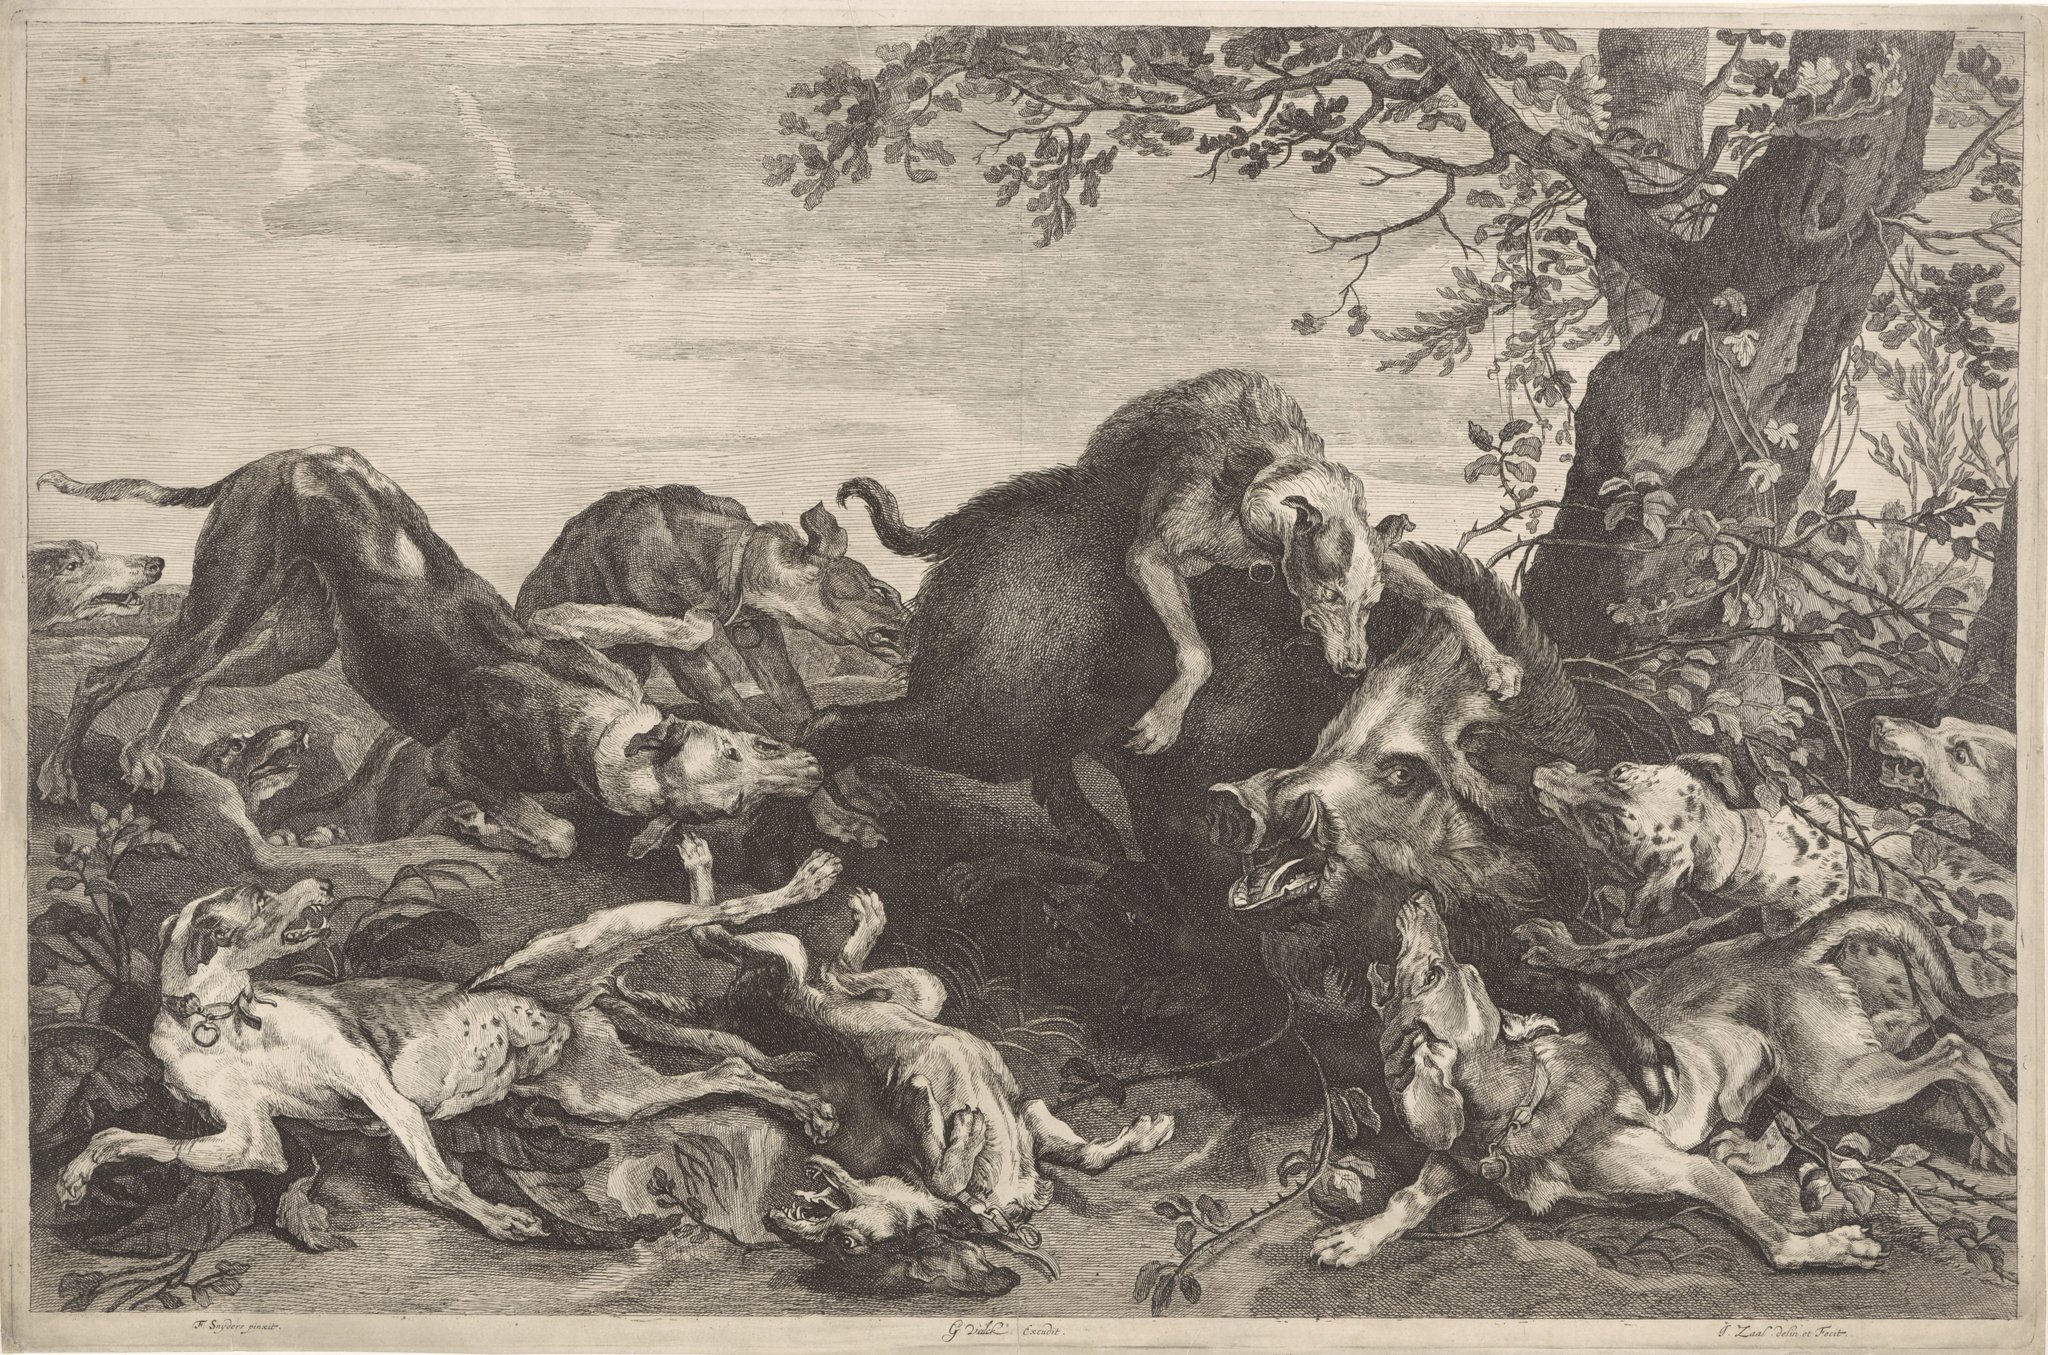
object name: print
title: Jacht op een wild zwijn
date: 1665-1670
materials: paper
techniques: engraving, etching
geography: amsterdam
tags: hunting dogs, boar-hunting, hoofed animals: boar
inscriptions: collector's mark: Lugt 2228, collector's mark: Lugt 2166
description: Een wild zwijn wordt van alle kanten aangevallen door jachthonden.